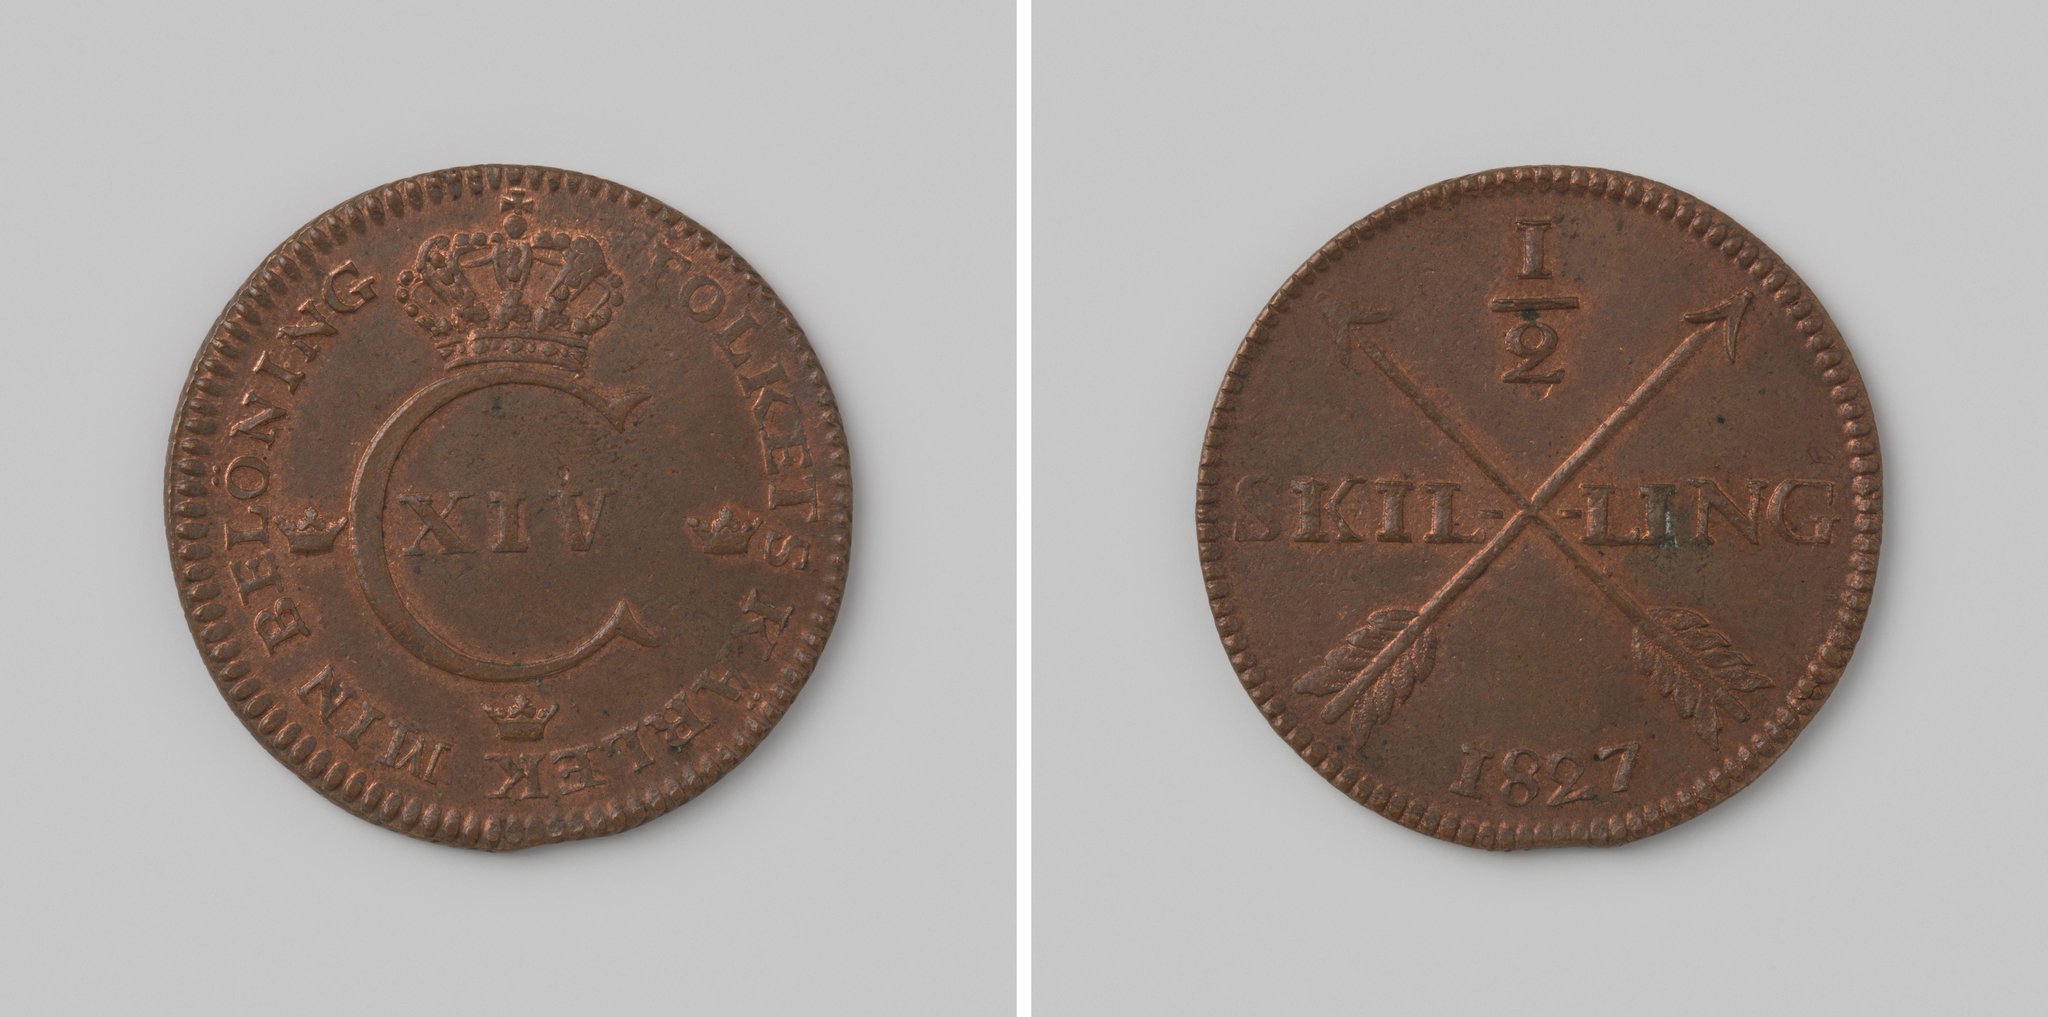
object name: coin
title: ½ skilling uit Zweden van Karel XIV Johan, 1827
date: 1827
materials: copper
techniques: striking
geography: slot rörstrand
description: Koperen munt. Voorzijde: tussen drie kronen monogram van de vorst, waarboven koningskroon. Keerzijde: twee gekruiste pijlen. Waarde-aanduiding in het veld. Jaartal onderaan. Kabelrand.